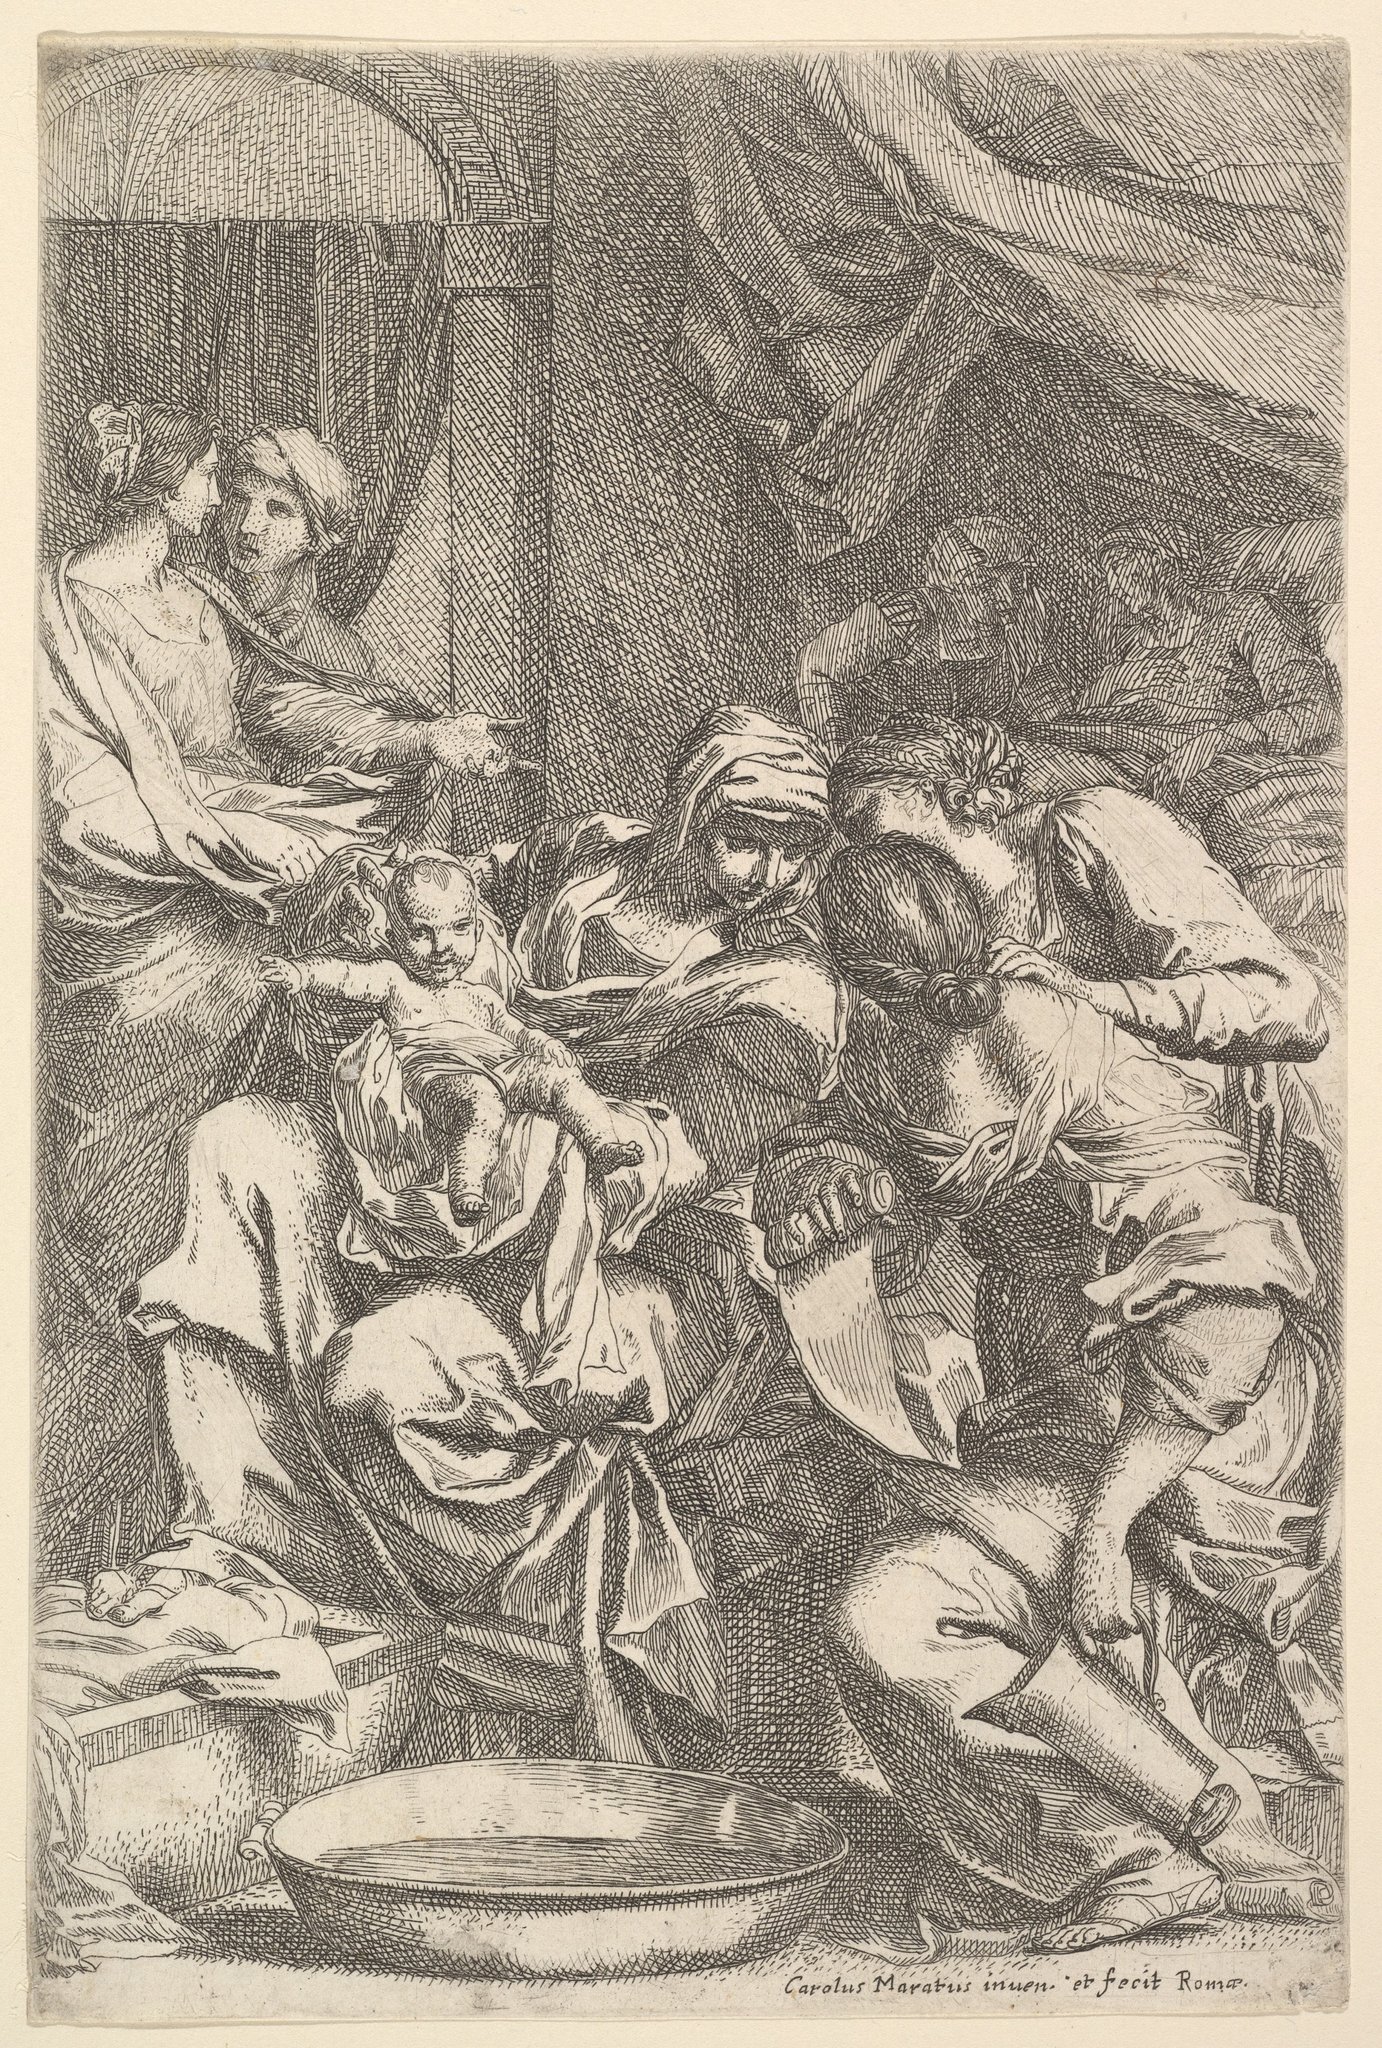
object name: print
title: The Birth of the Virgin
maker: carlo maratti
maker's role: artist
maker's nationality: italian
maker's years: 1625-1713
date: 1601-1700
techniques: etching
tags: women,virgin mary,nativity